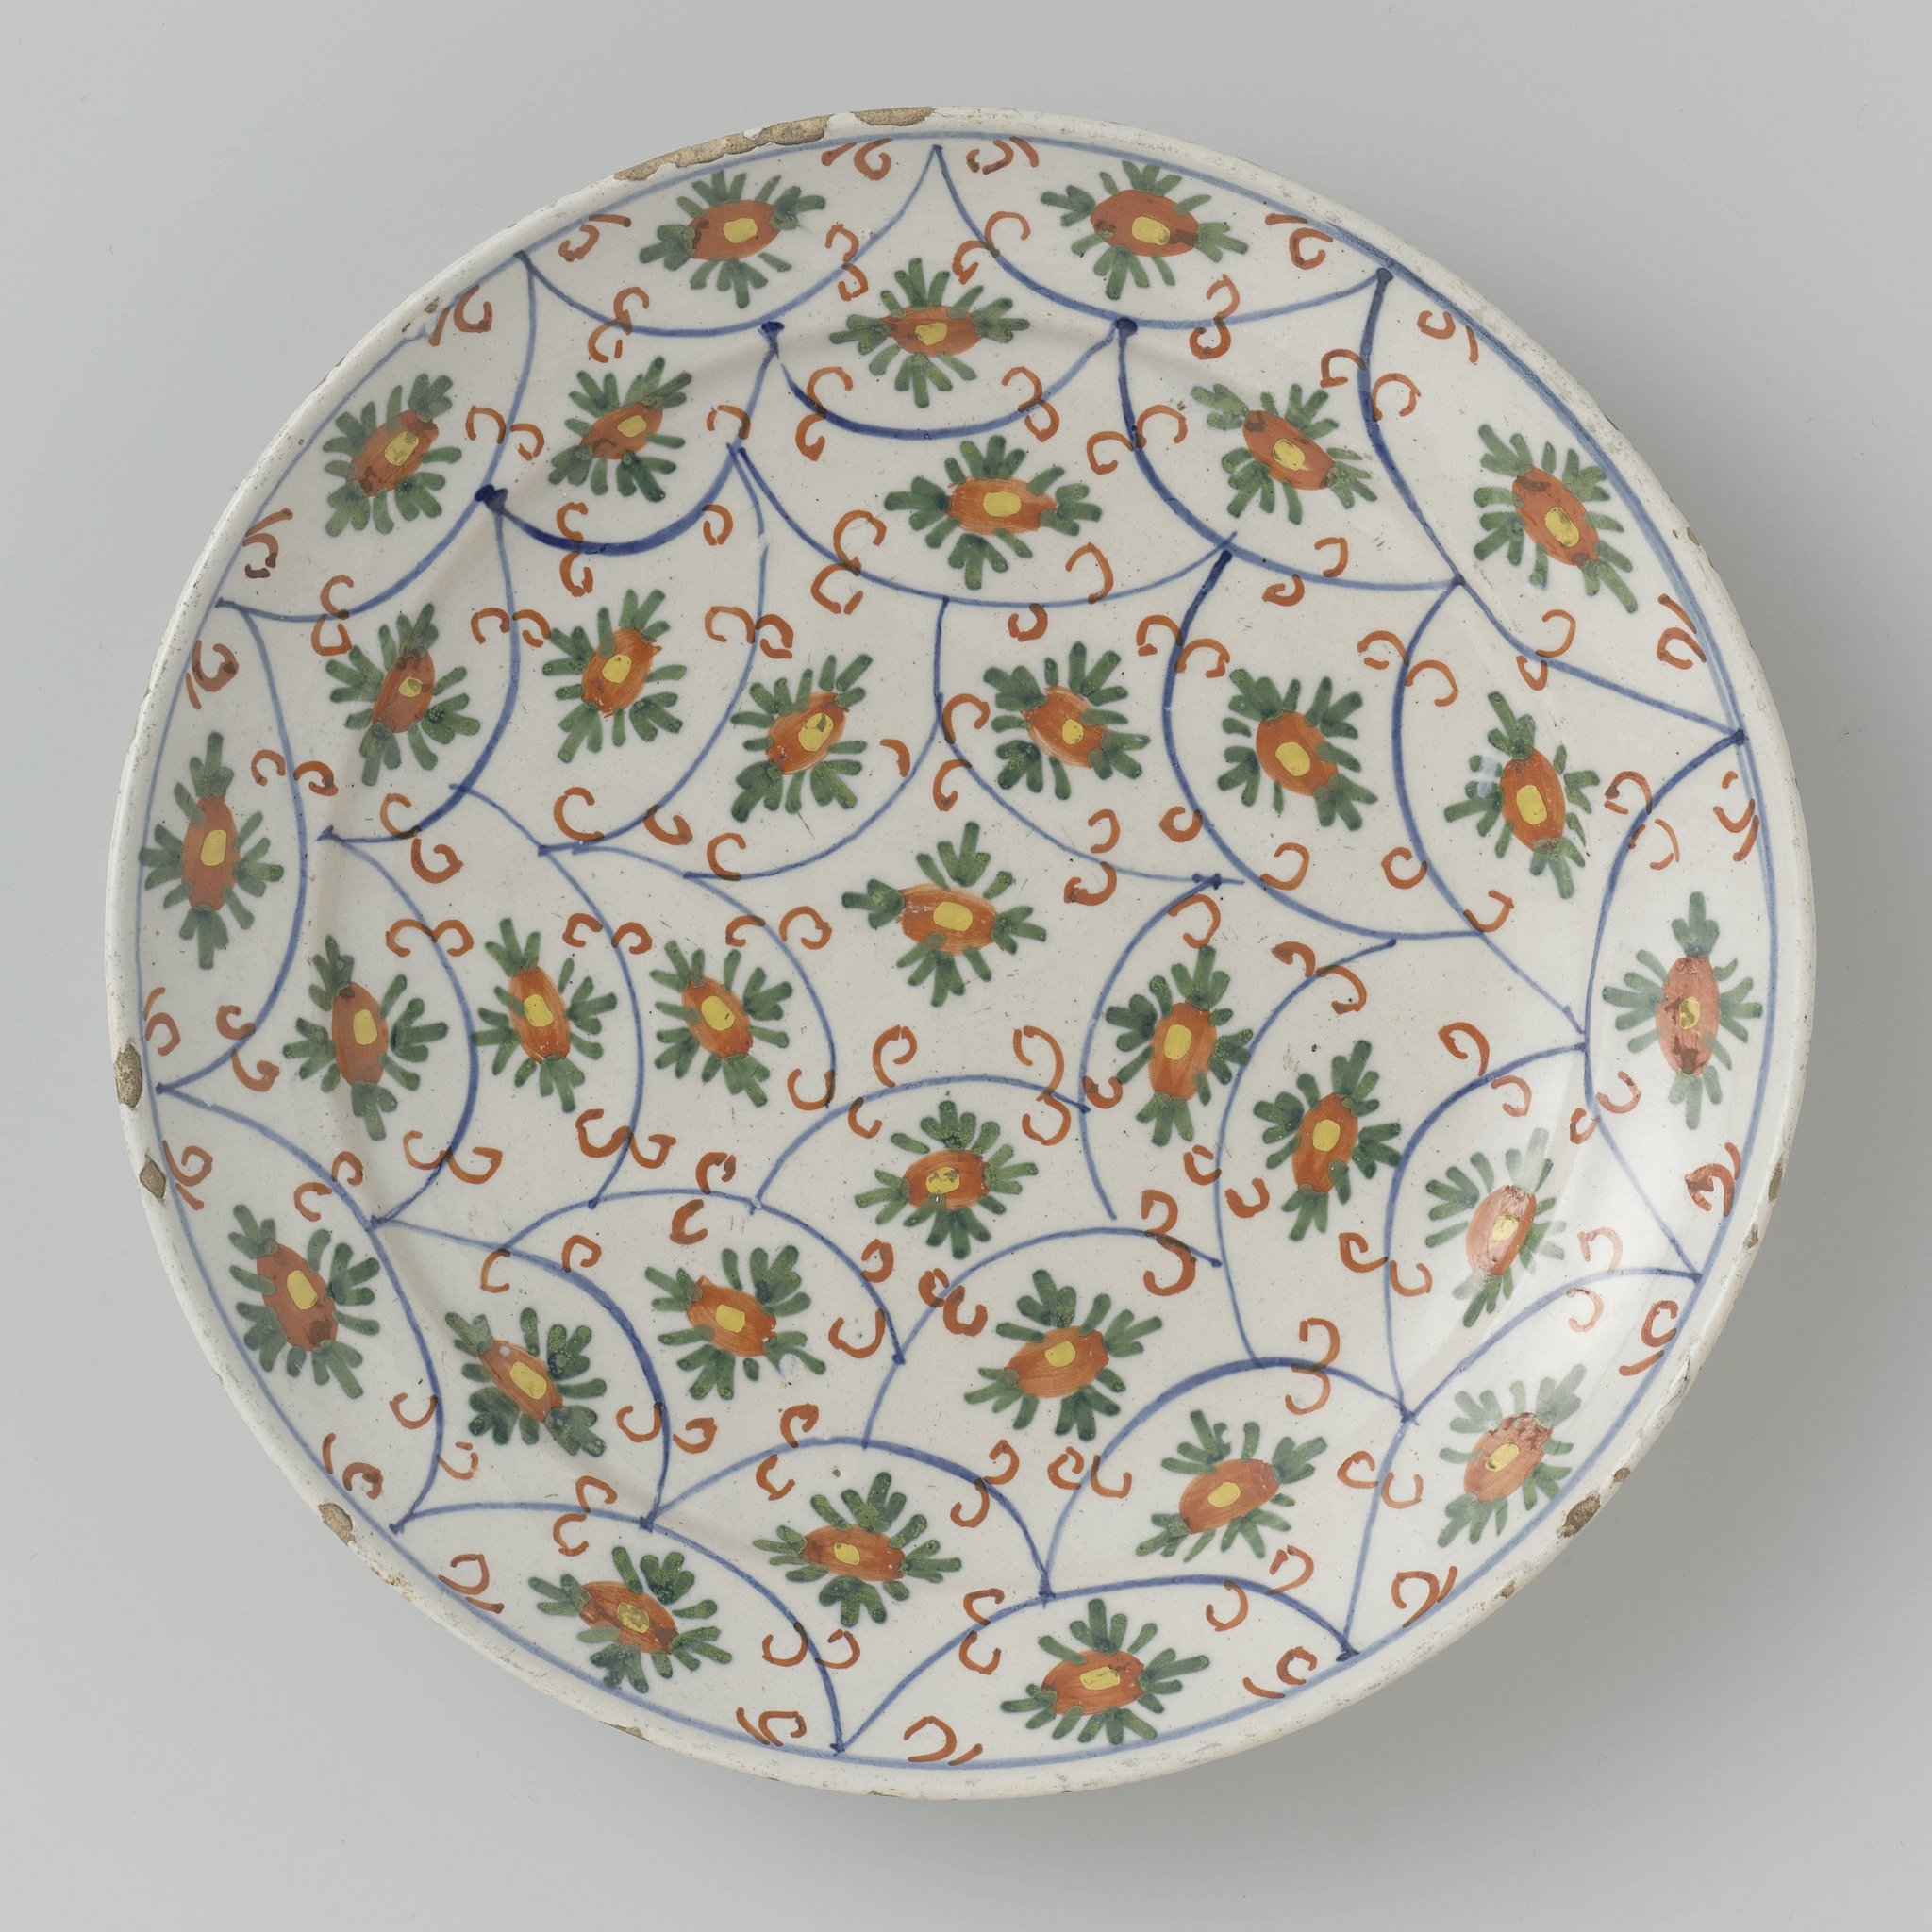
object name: plate dish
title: Bord van veelkleurig beschilderde faïence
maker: Anonymous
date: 1730-1770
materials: faience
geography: delft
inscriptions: inscription: ‘4’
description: Bord van faience. Veelkleurig beschilderd.